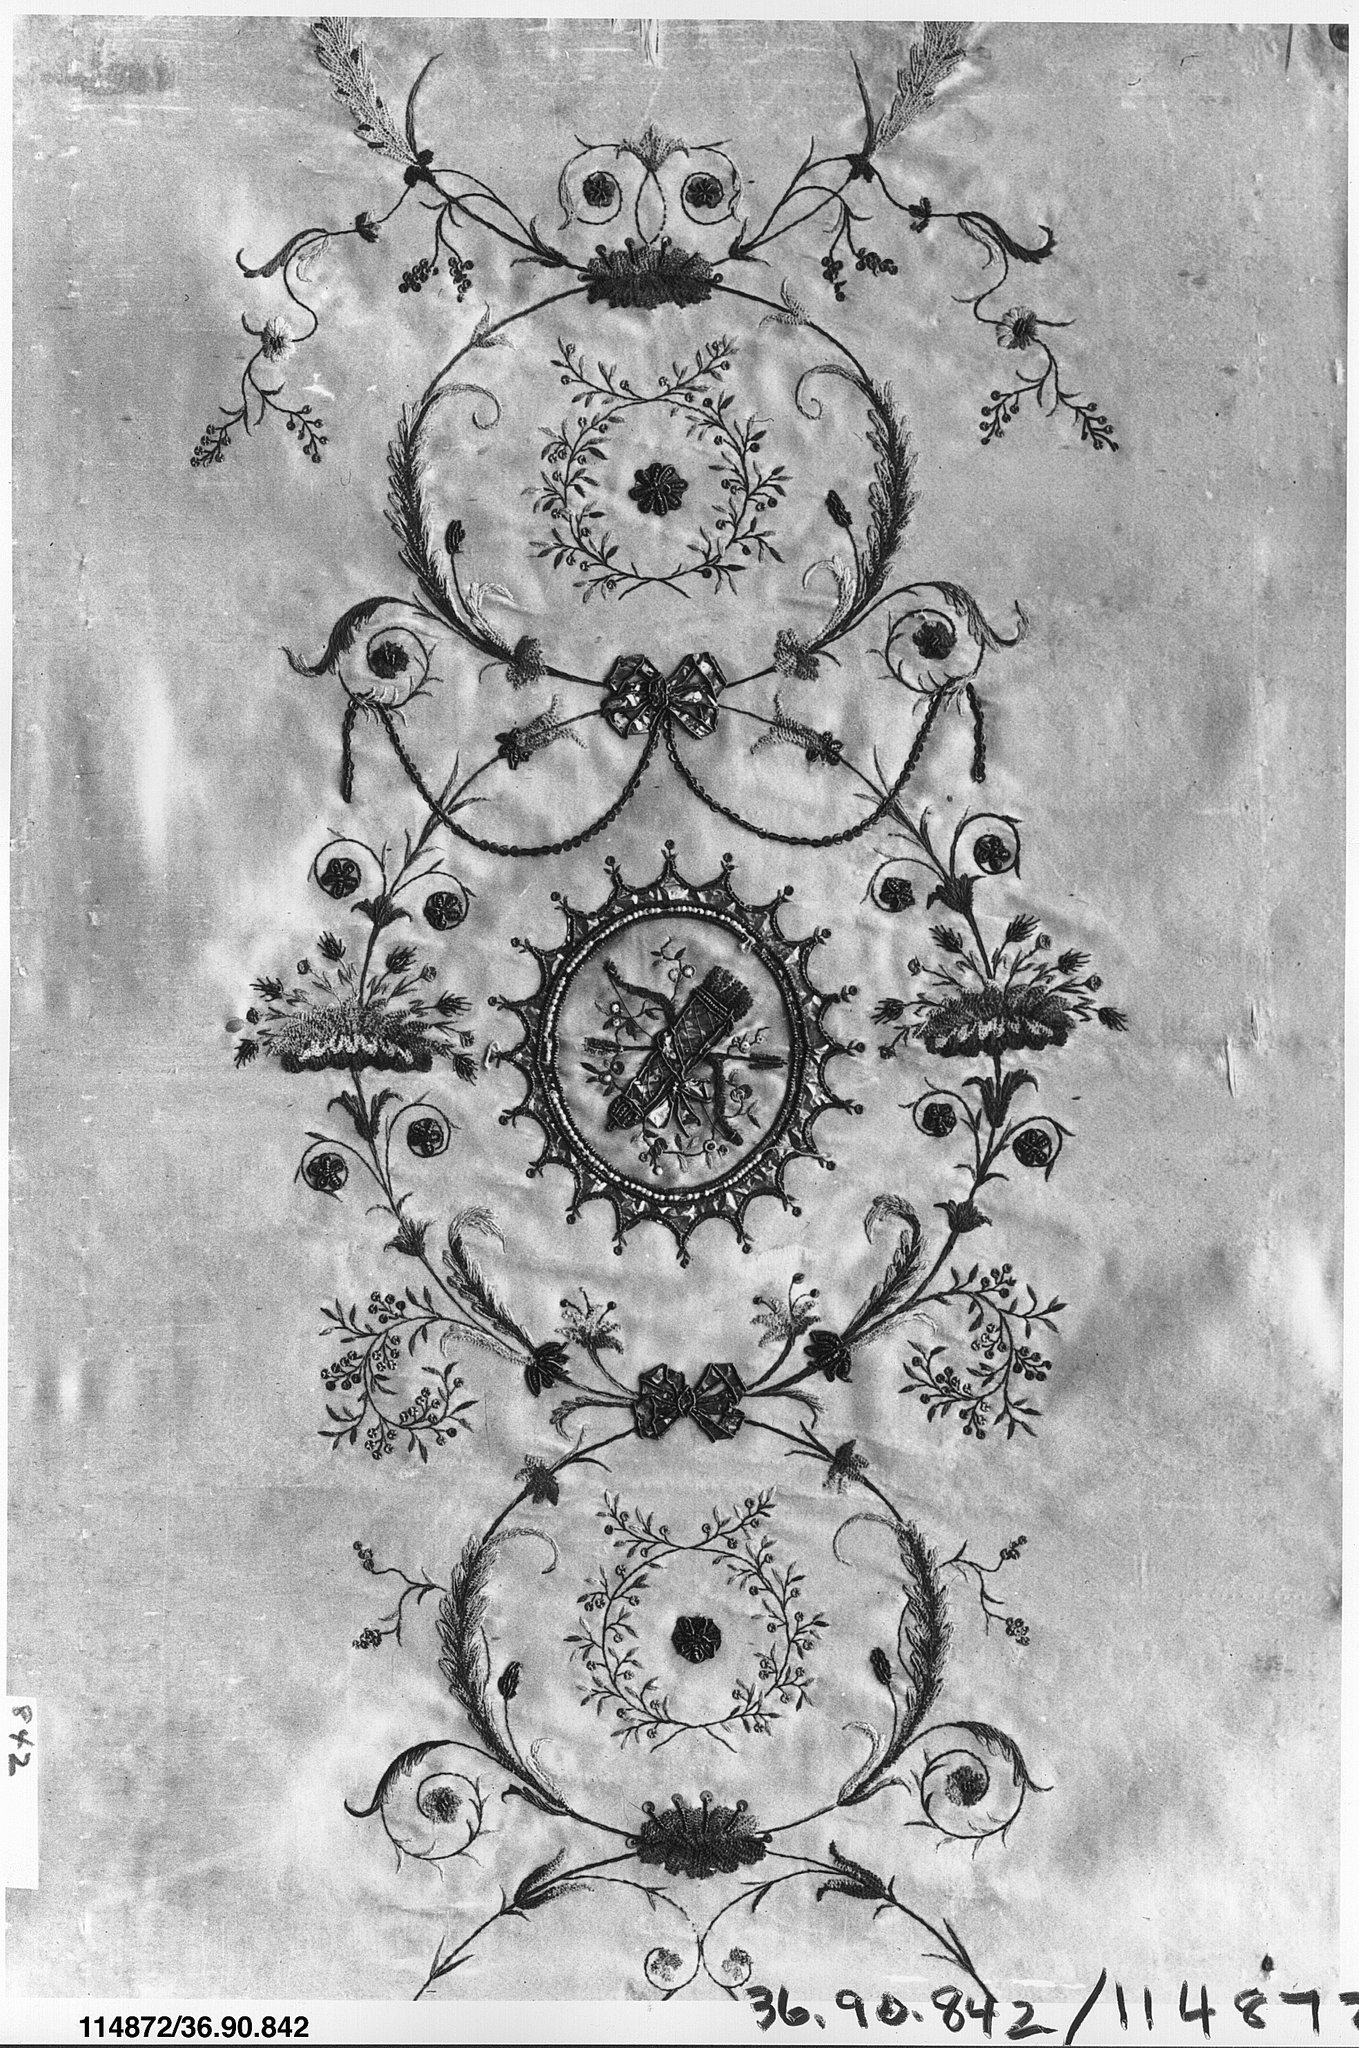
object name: piece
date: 1701-1800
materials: metal thread, silk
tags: bow and arrow,flowers,leaves